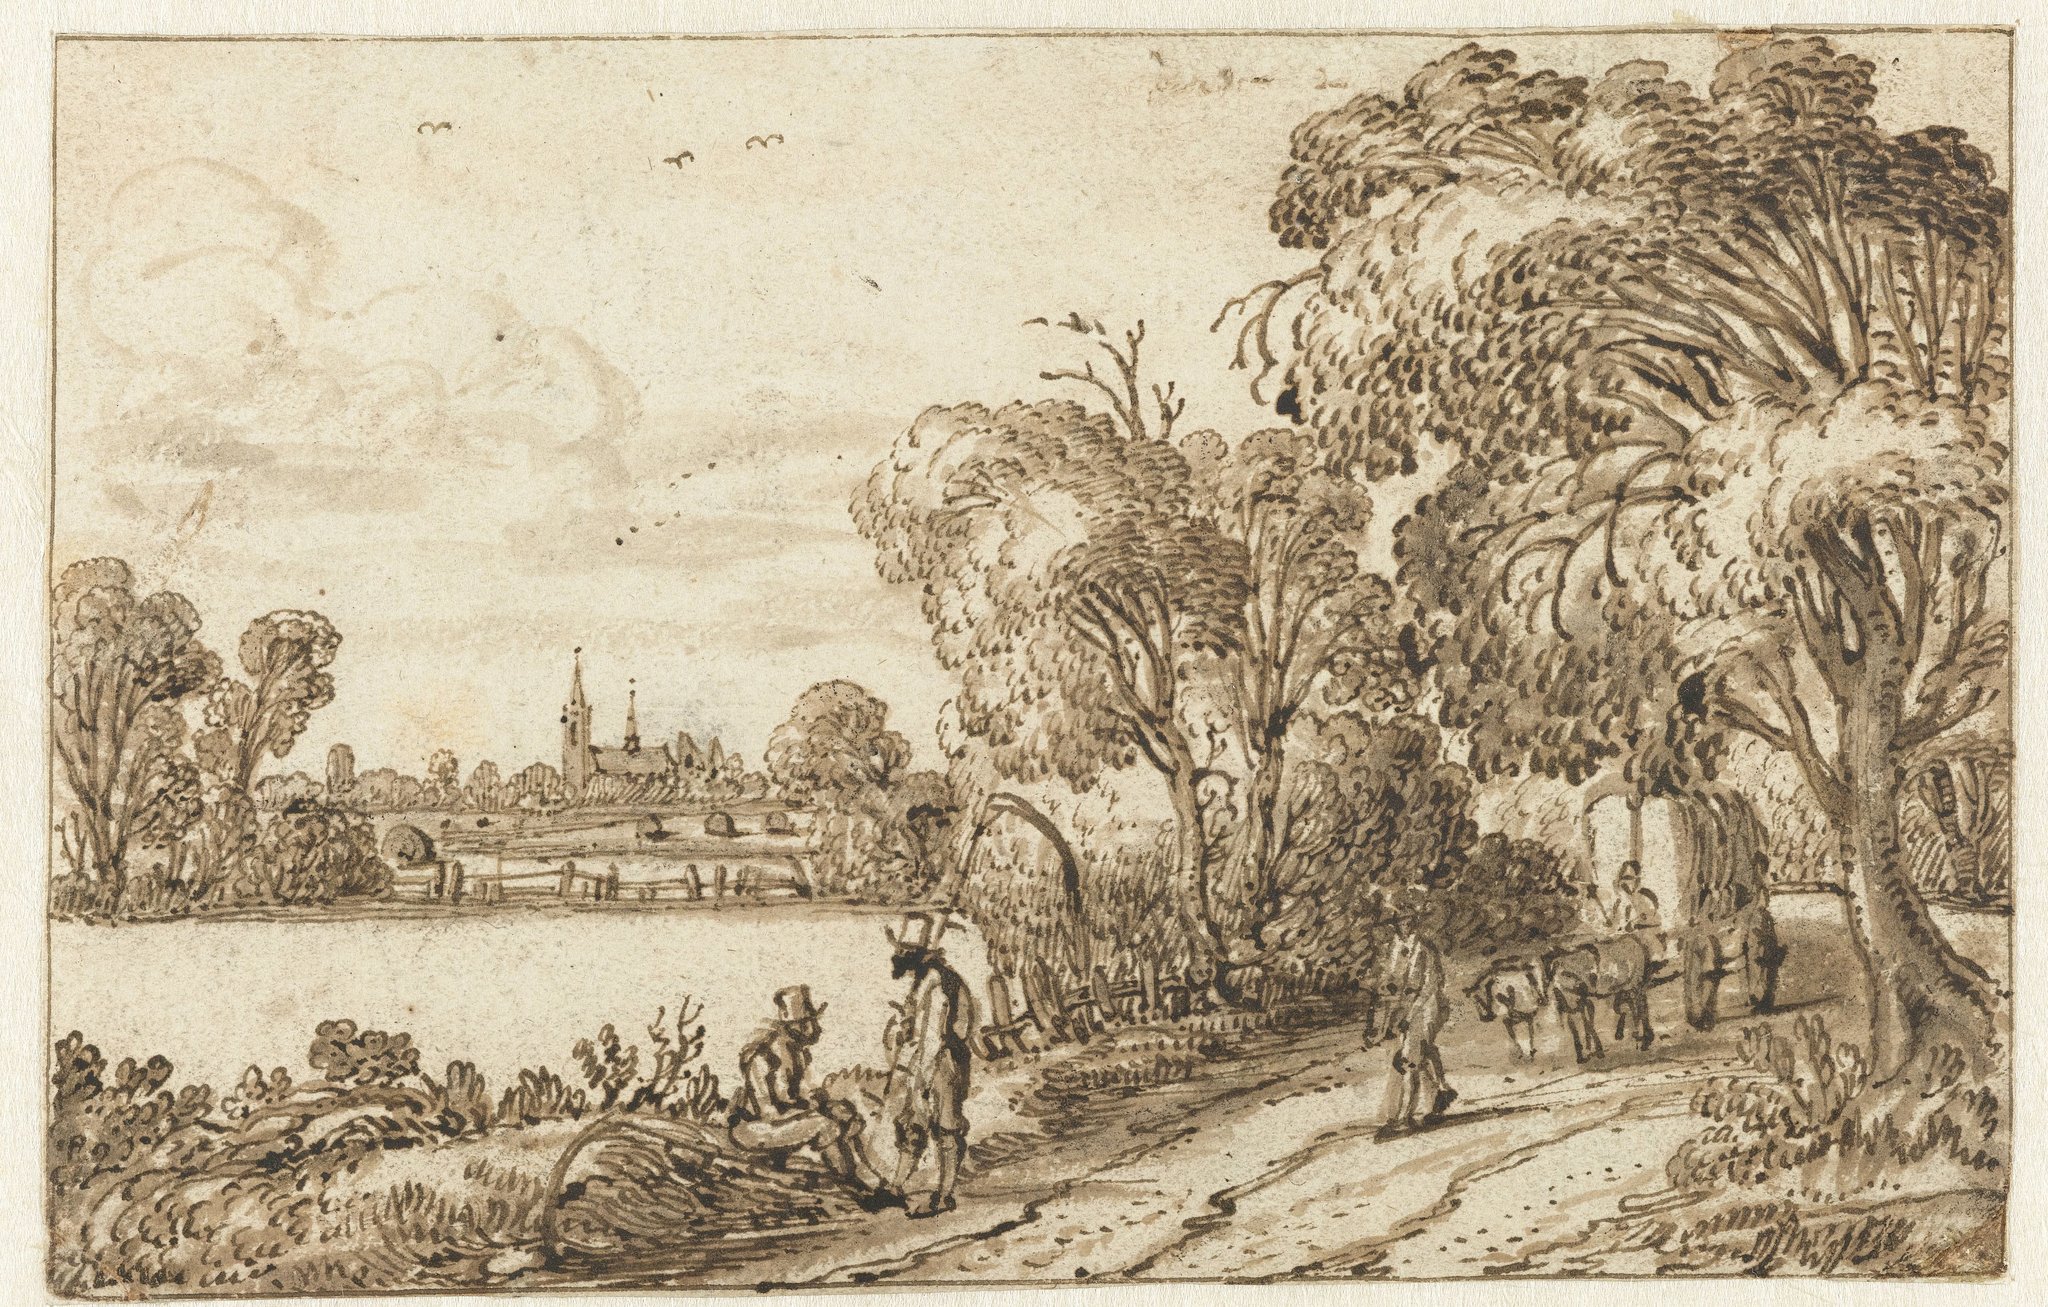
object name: drawing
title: Landschap met weg tussen velden en bos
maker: esaias van de velde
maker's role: draughtsman, painter, print maker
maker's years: 1587-1630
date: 1600-1680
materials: ink, paper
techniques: brush, pen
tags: landscapes in the temperate zone